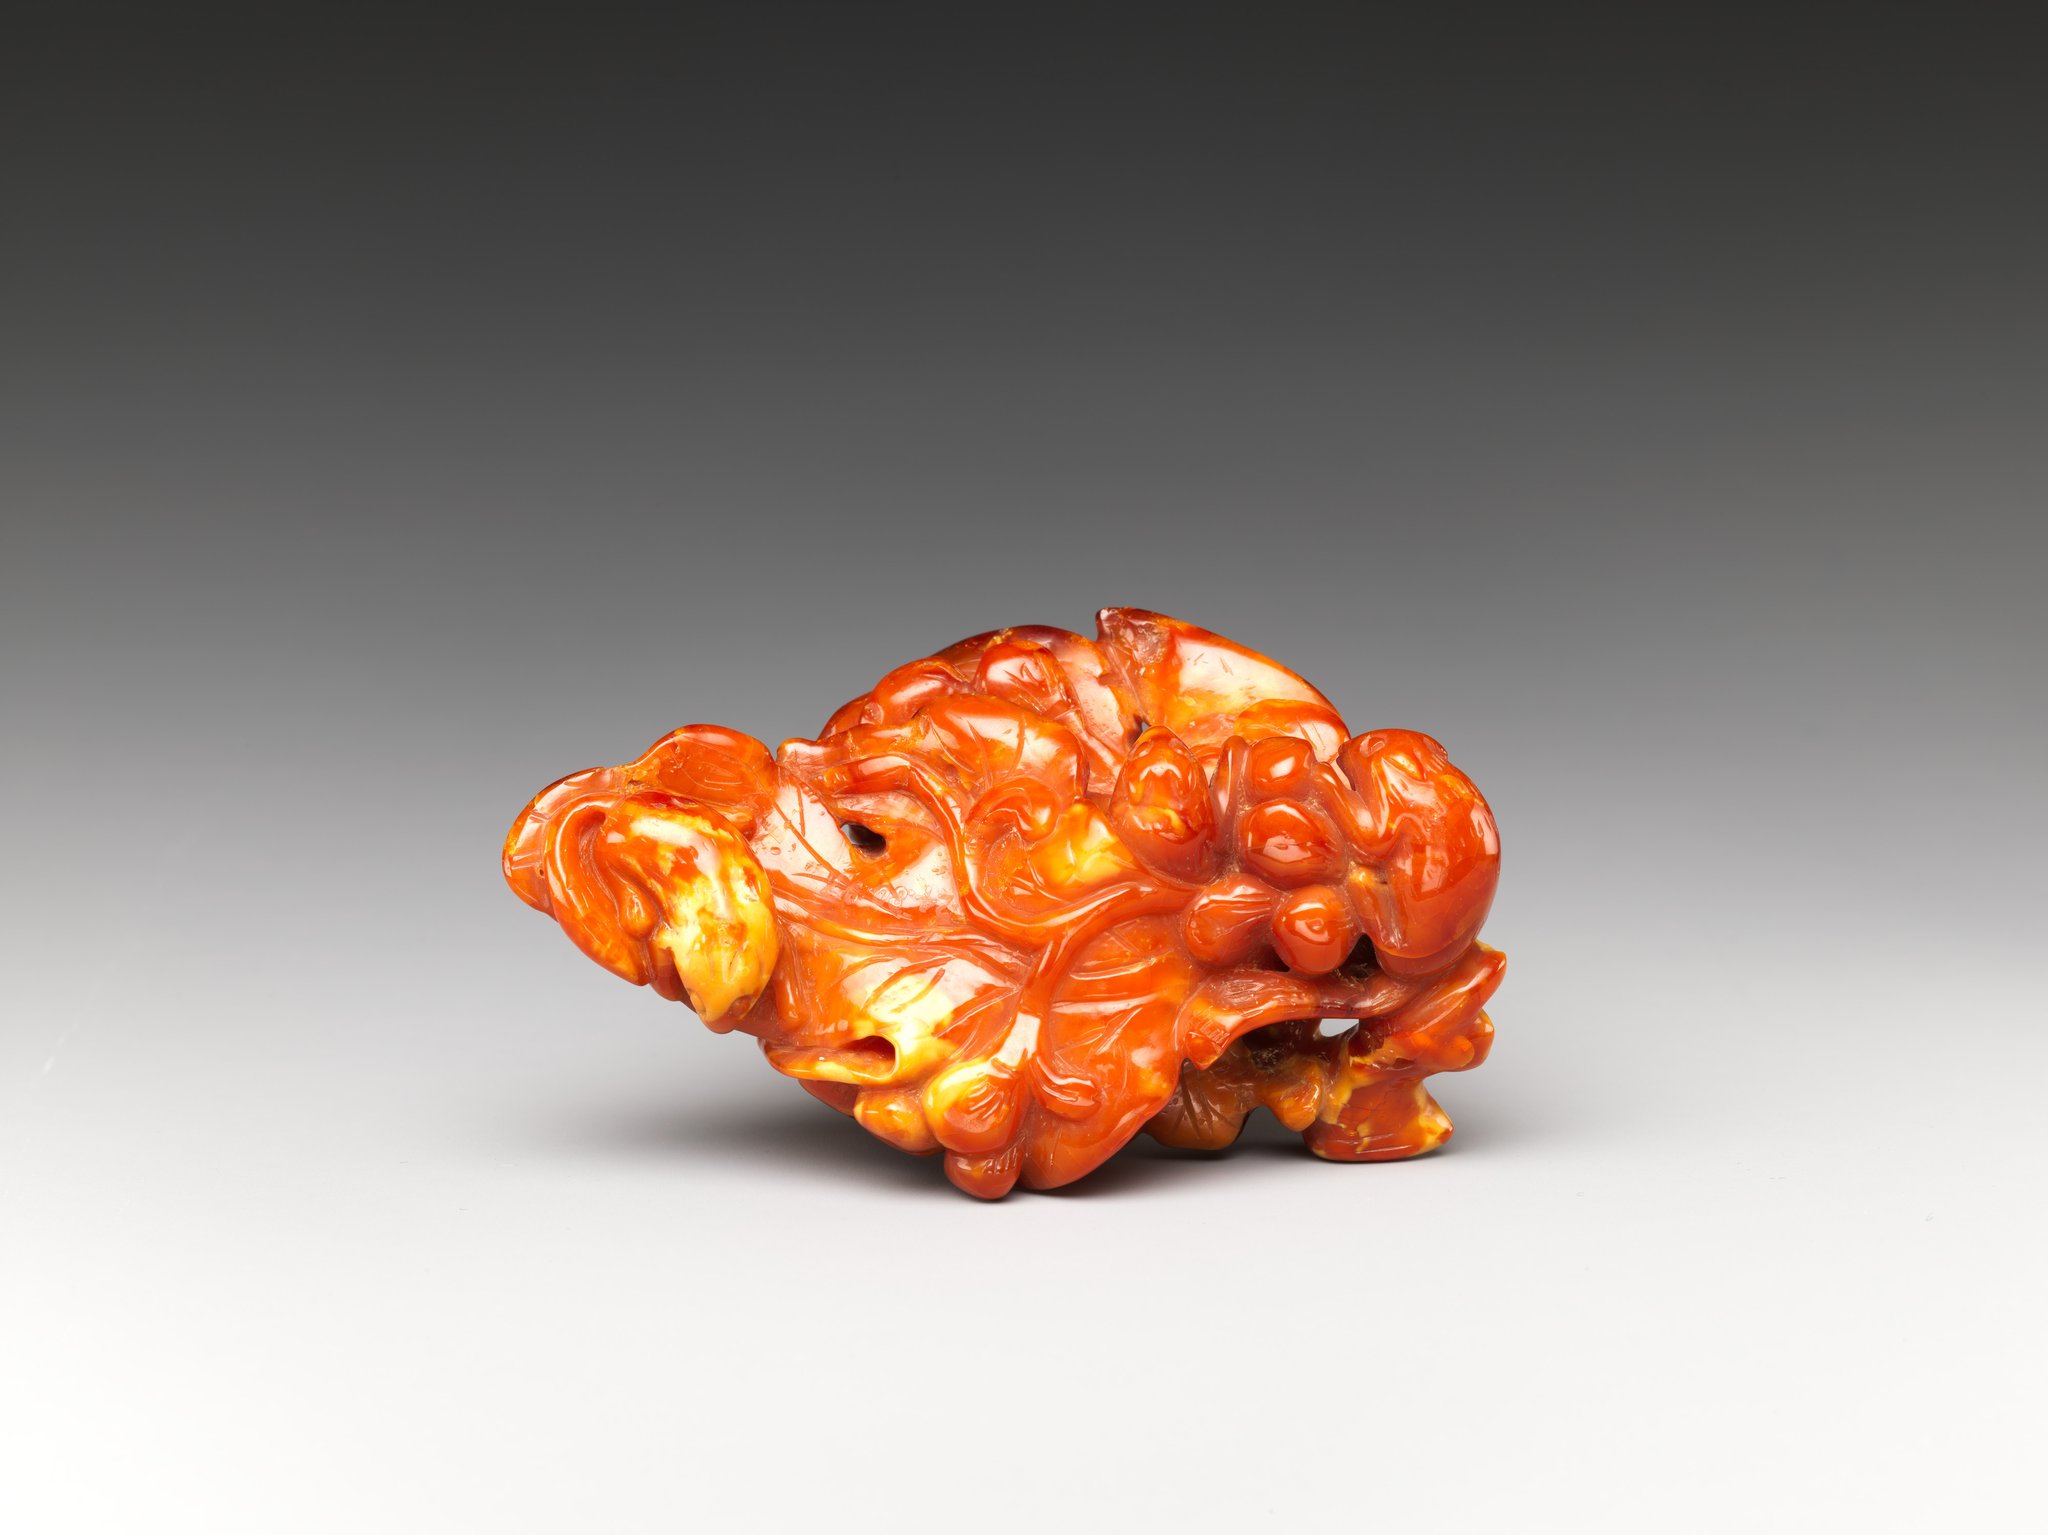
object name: ornament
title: Ornament with Squirrels and Grapes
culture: chinese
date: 1701-1800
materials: amber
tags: grapes